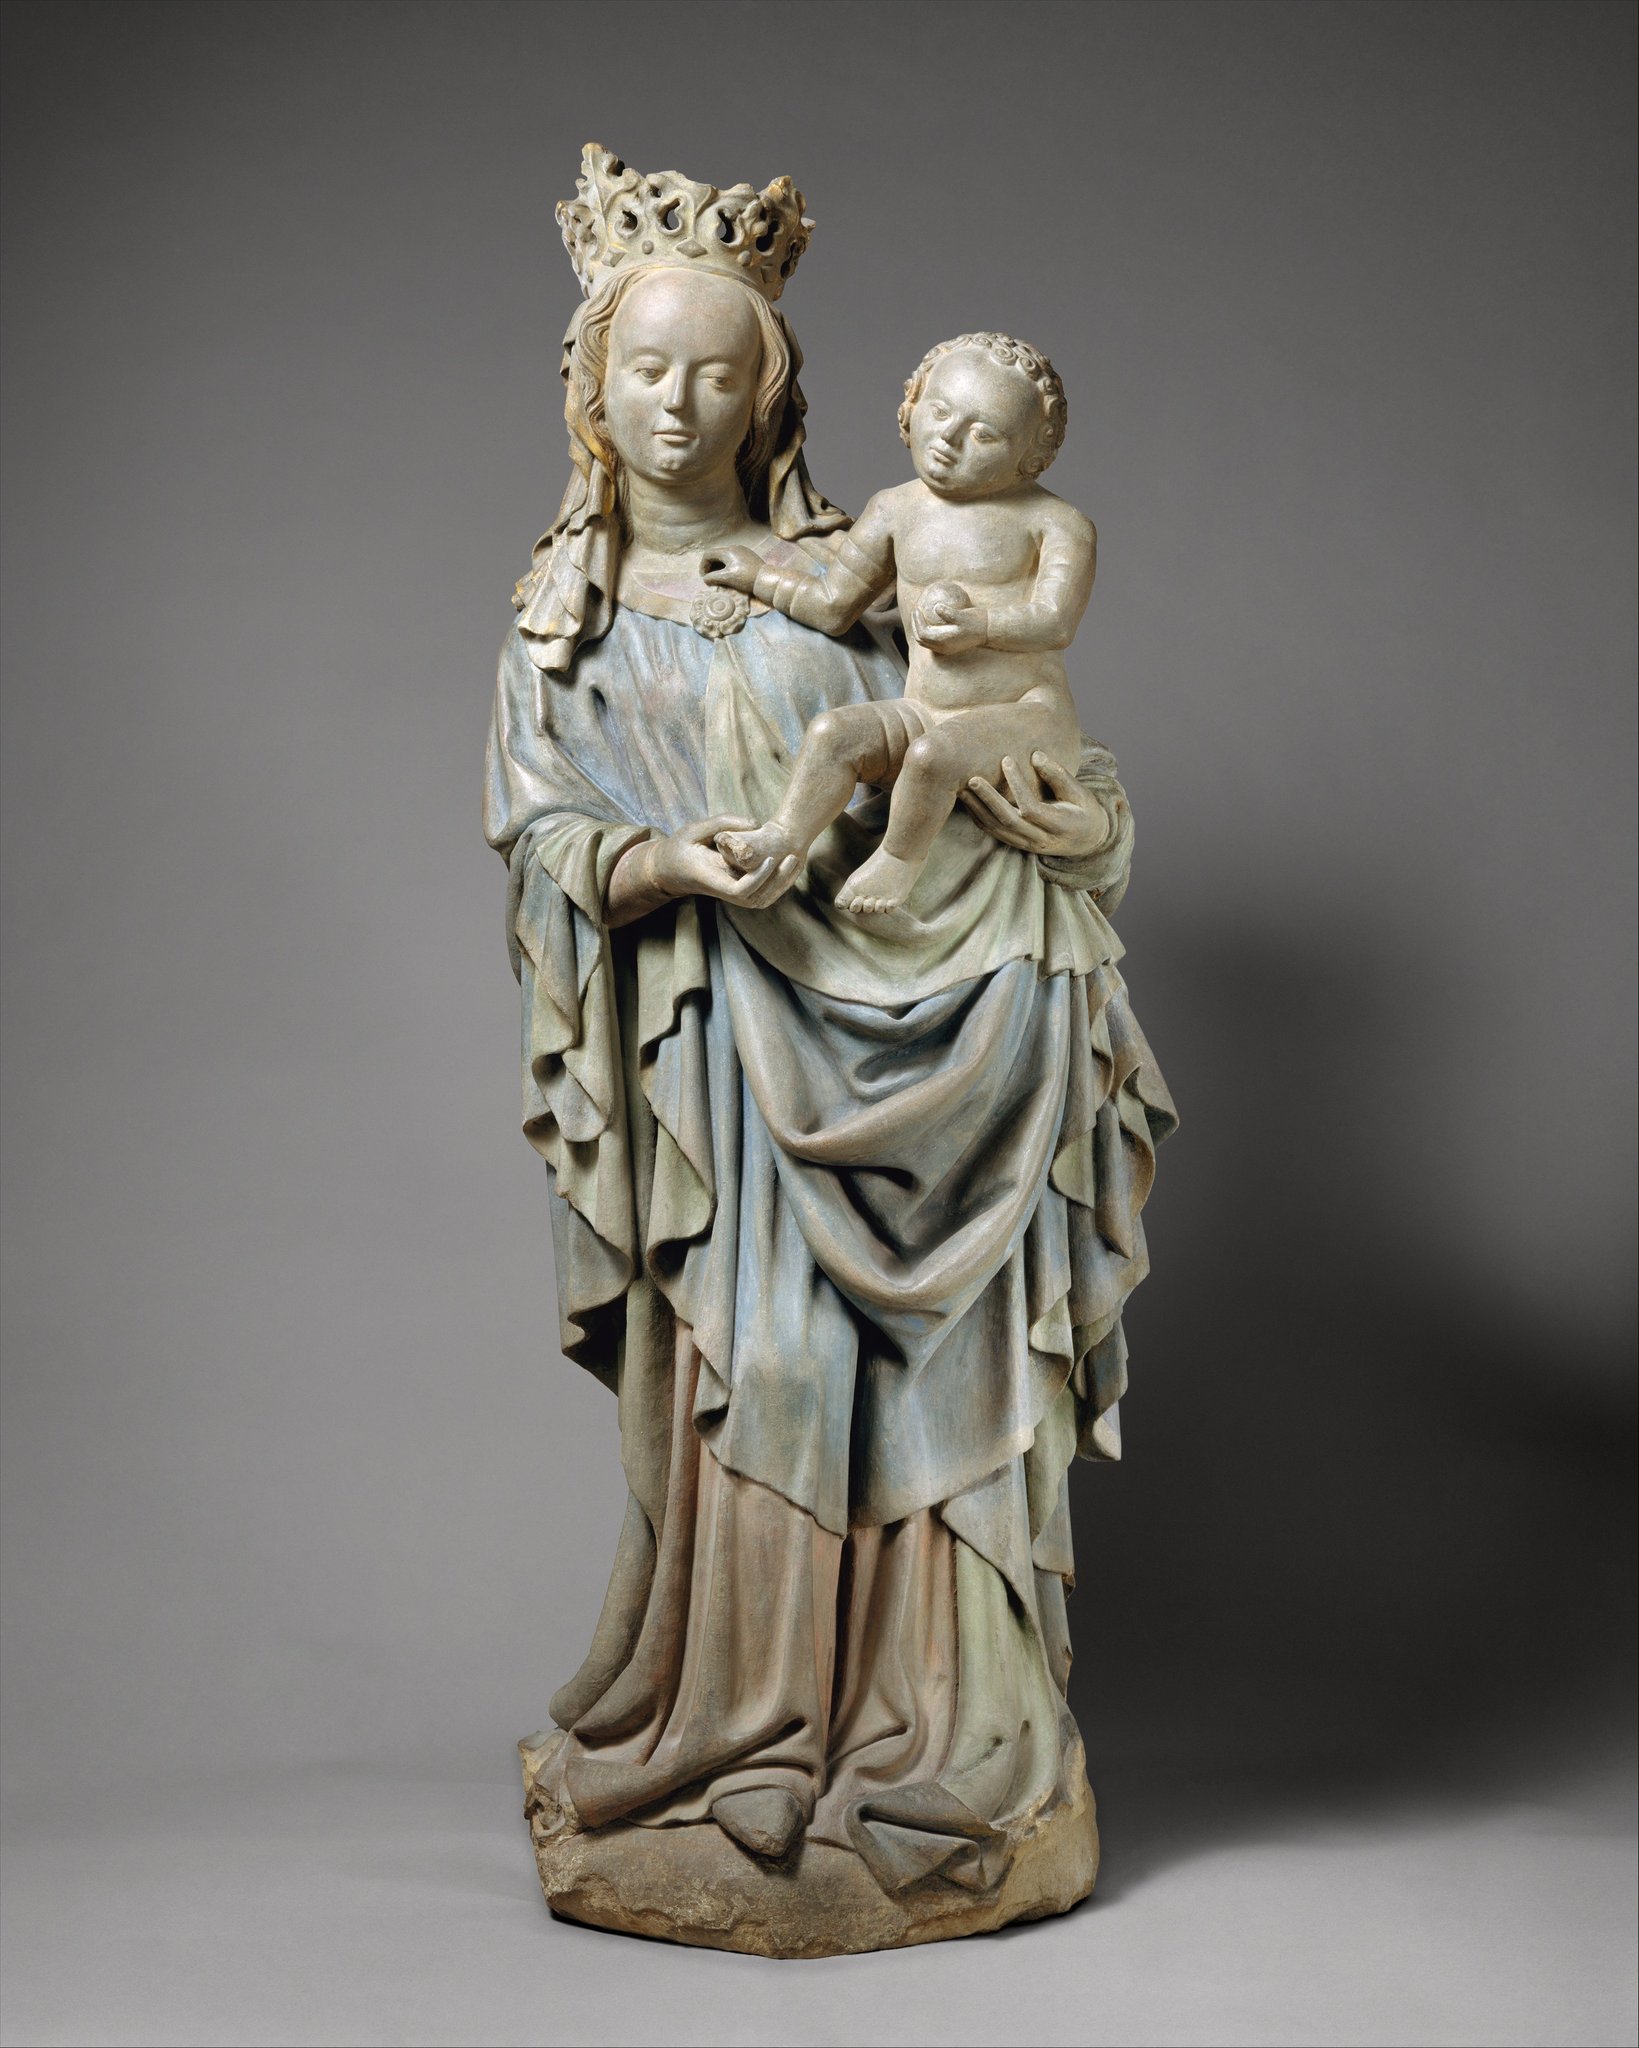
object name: statue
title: Virgin and Child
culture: german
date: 1425-1430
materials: stone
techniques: polychromy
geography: nuremberg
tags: madonna and child